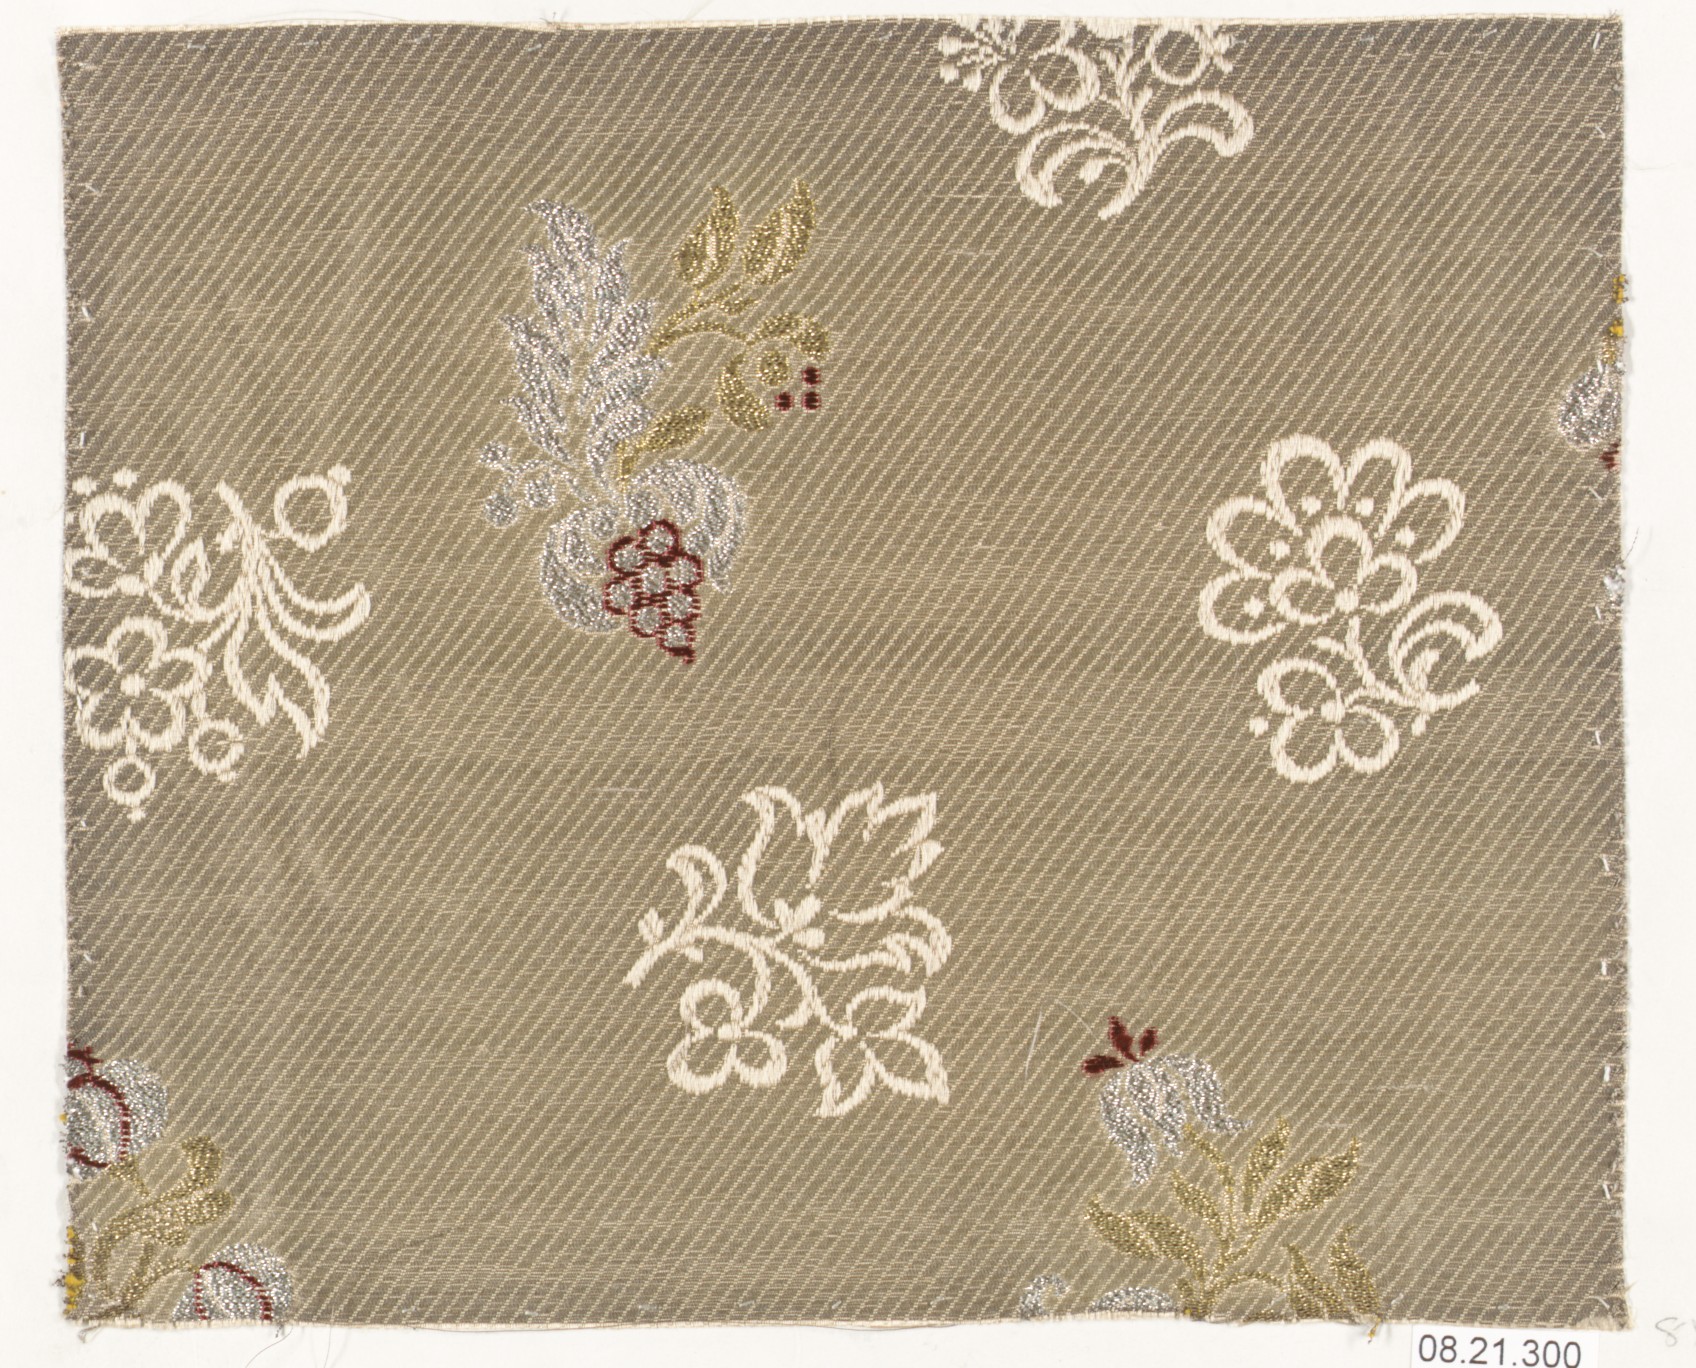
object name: textile sample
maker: Anonymous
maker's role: designer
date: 1900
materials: silk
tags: flowers